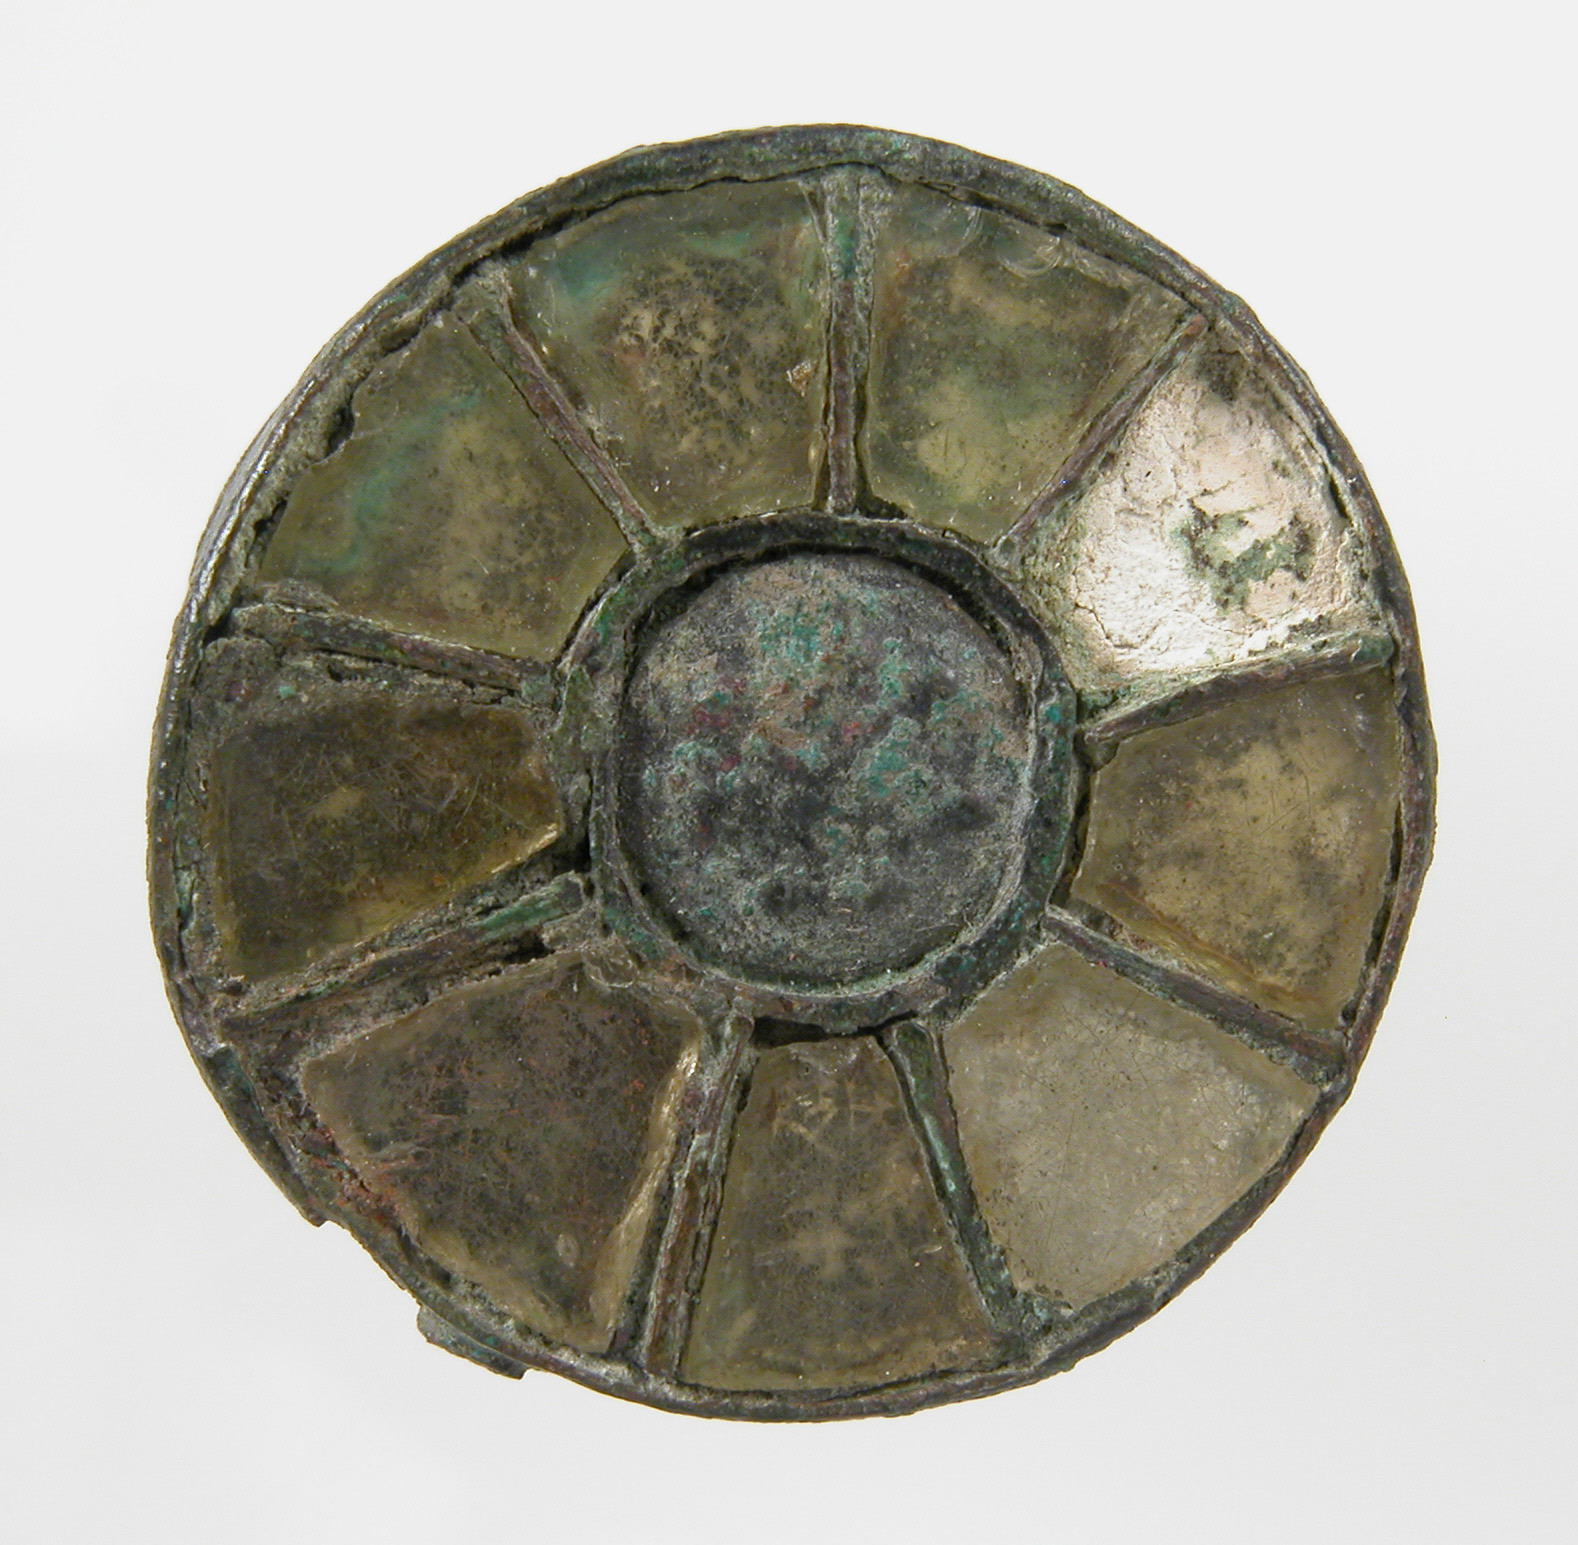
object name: brooch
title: Disk Brooch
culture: frankish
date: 501-600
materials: copper alloy, glass, iron, paste